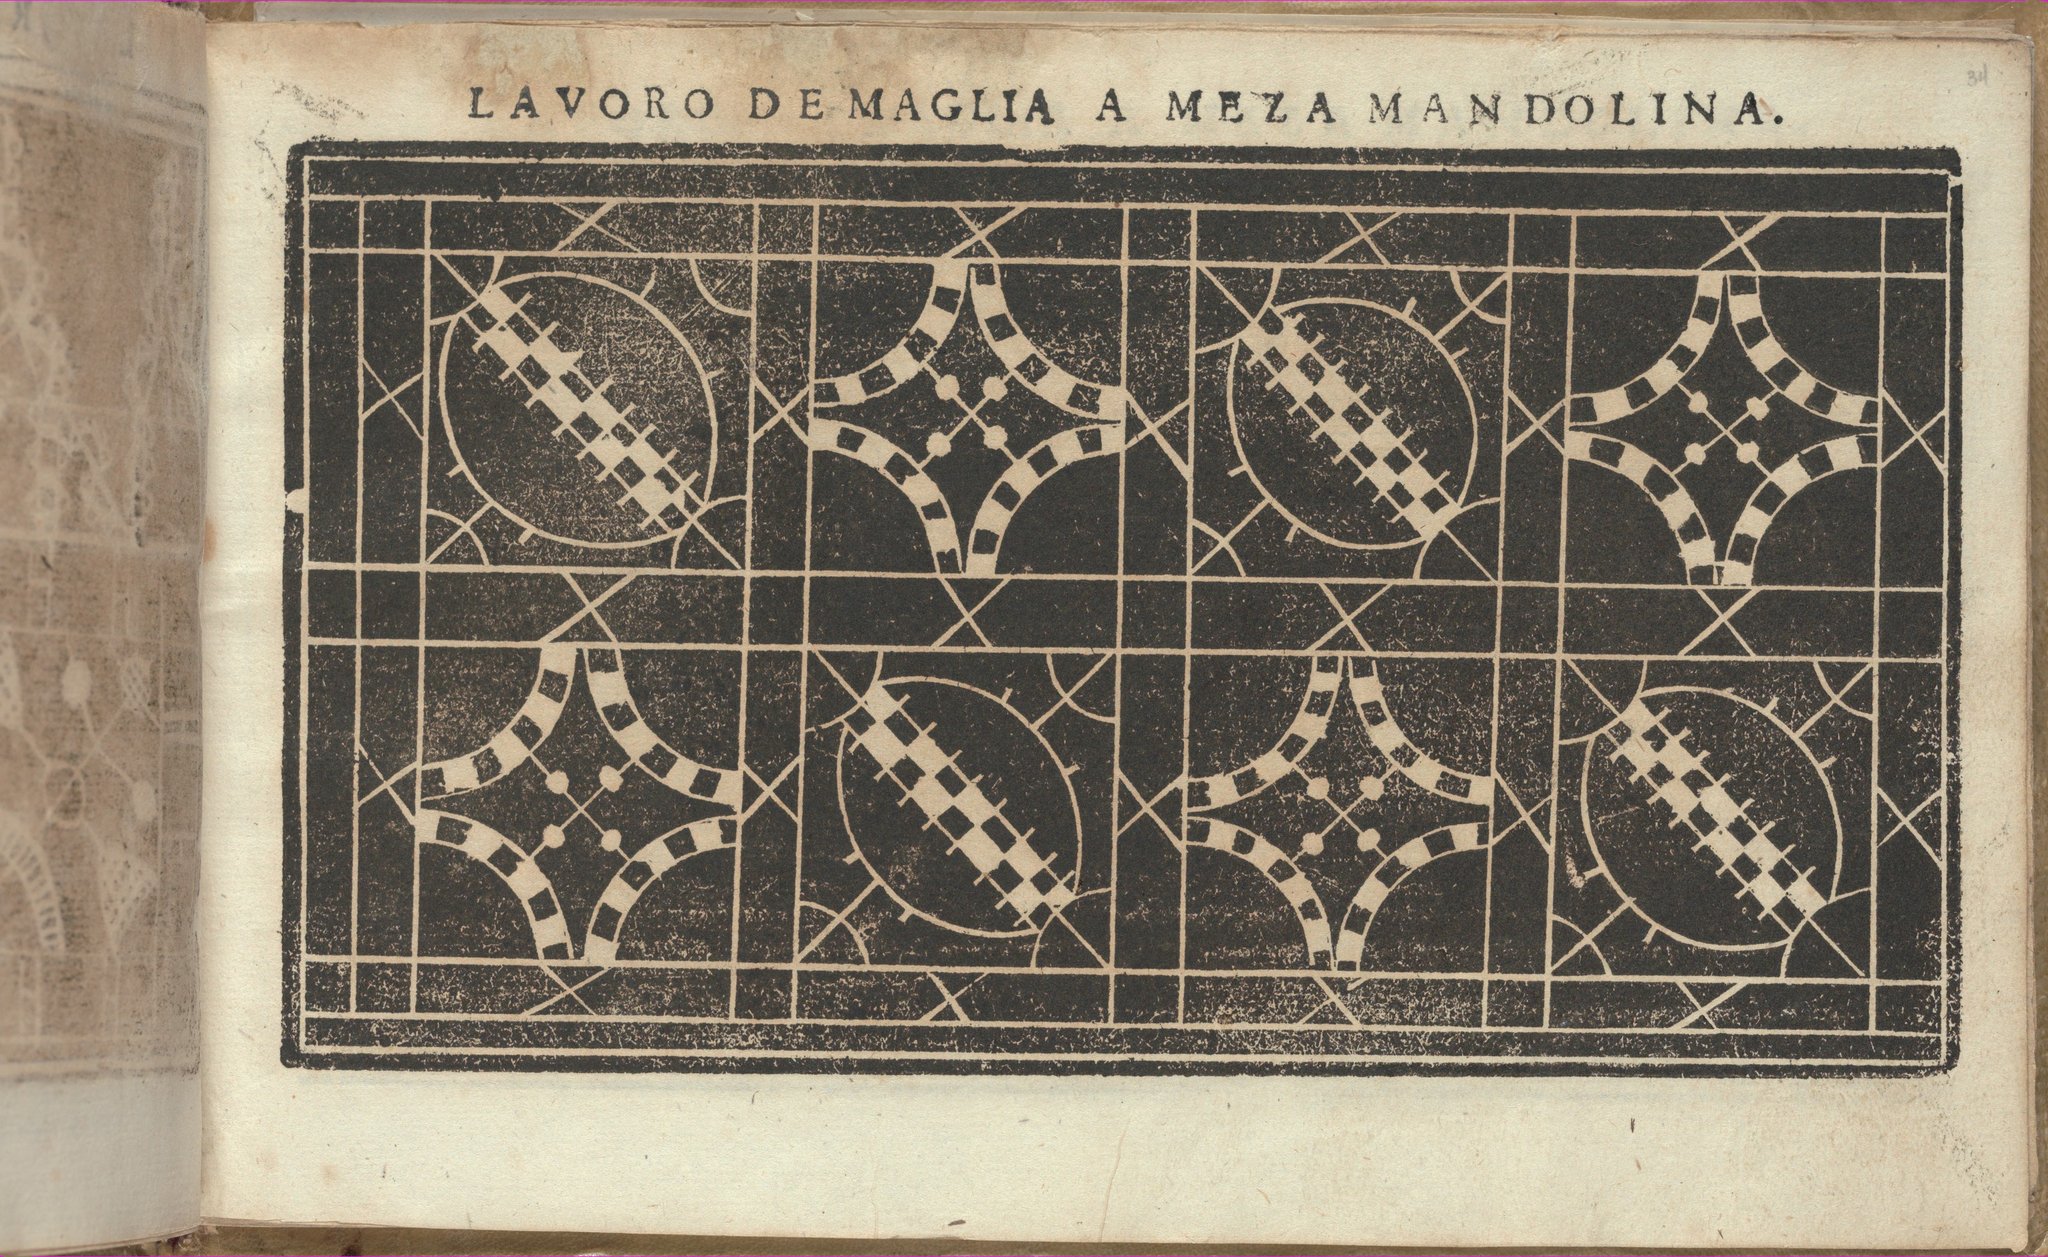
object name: book print ornament architecture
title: Studio delle virtuose Dame, page 34 (recto)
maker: isabella catanea parasole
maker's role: designer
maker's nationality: italian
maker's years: 1565-1625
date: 1597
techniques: woodcut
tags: ornament